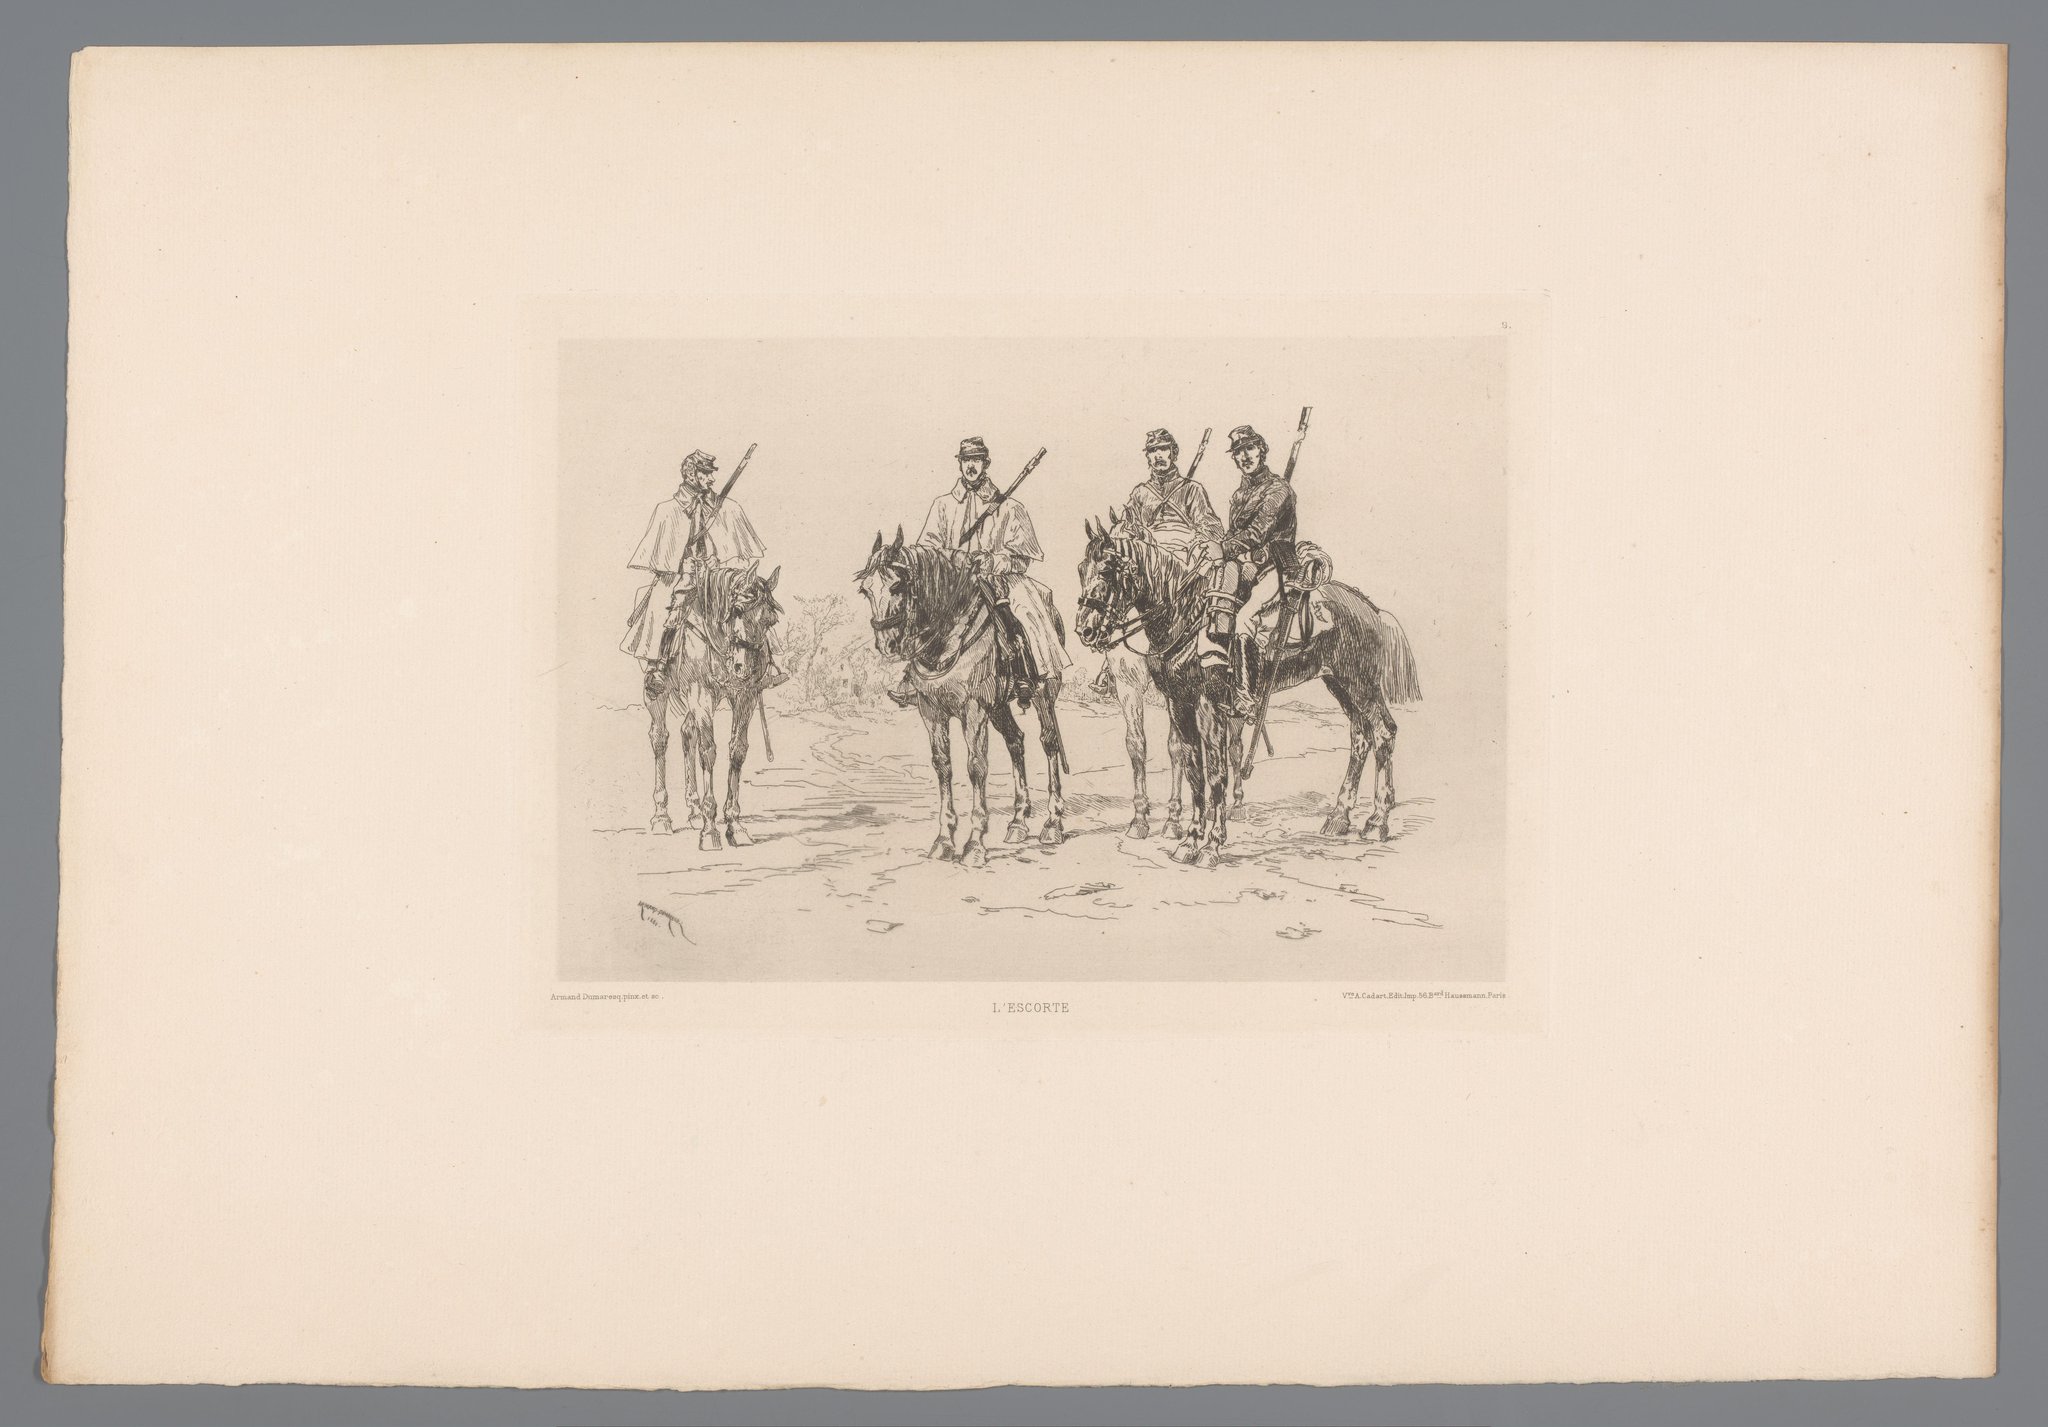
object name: print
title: Franse etsen uit 1881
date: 1881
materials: paper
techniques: drypoint, etching, intaglio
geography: paris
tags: animals used in the army, the soldier; the soldier's life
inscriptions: collector's mark: ‘AFE v S’, watermark, collector's mark: Lugt 2228, collector's mark: Lugt 2760